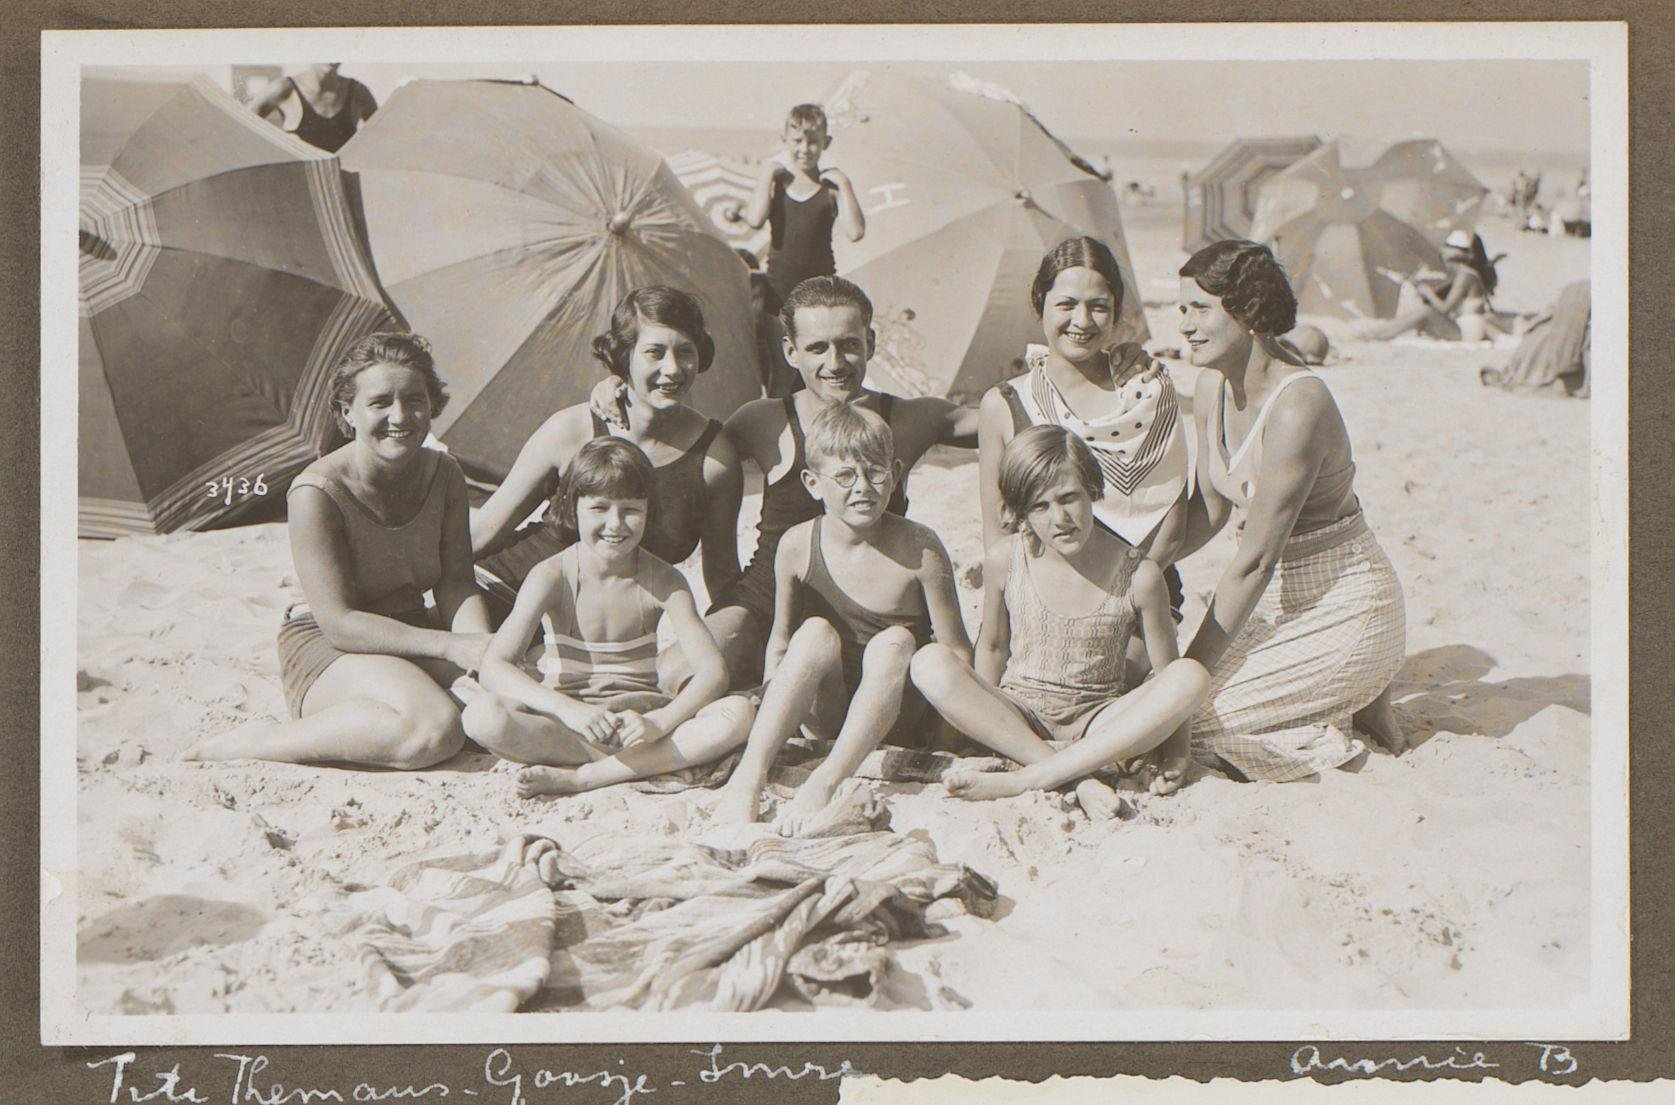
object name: album leaf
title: Groepsportret van een gezelschap op het strand van Scheveningen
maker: Anonymous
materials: paper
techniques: gelatin silver print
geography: scheveningen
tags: the hague, wilhelmina van zijll de jong, sunbathing (on the beach), historical persons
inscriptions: inscription: ‘Tete Themans - Goosje - Imre/ Korompay/ Annie B’